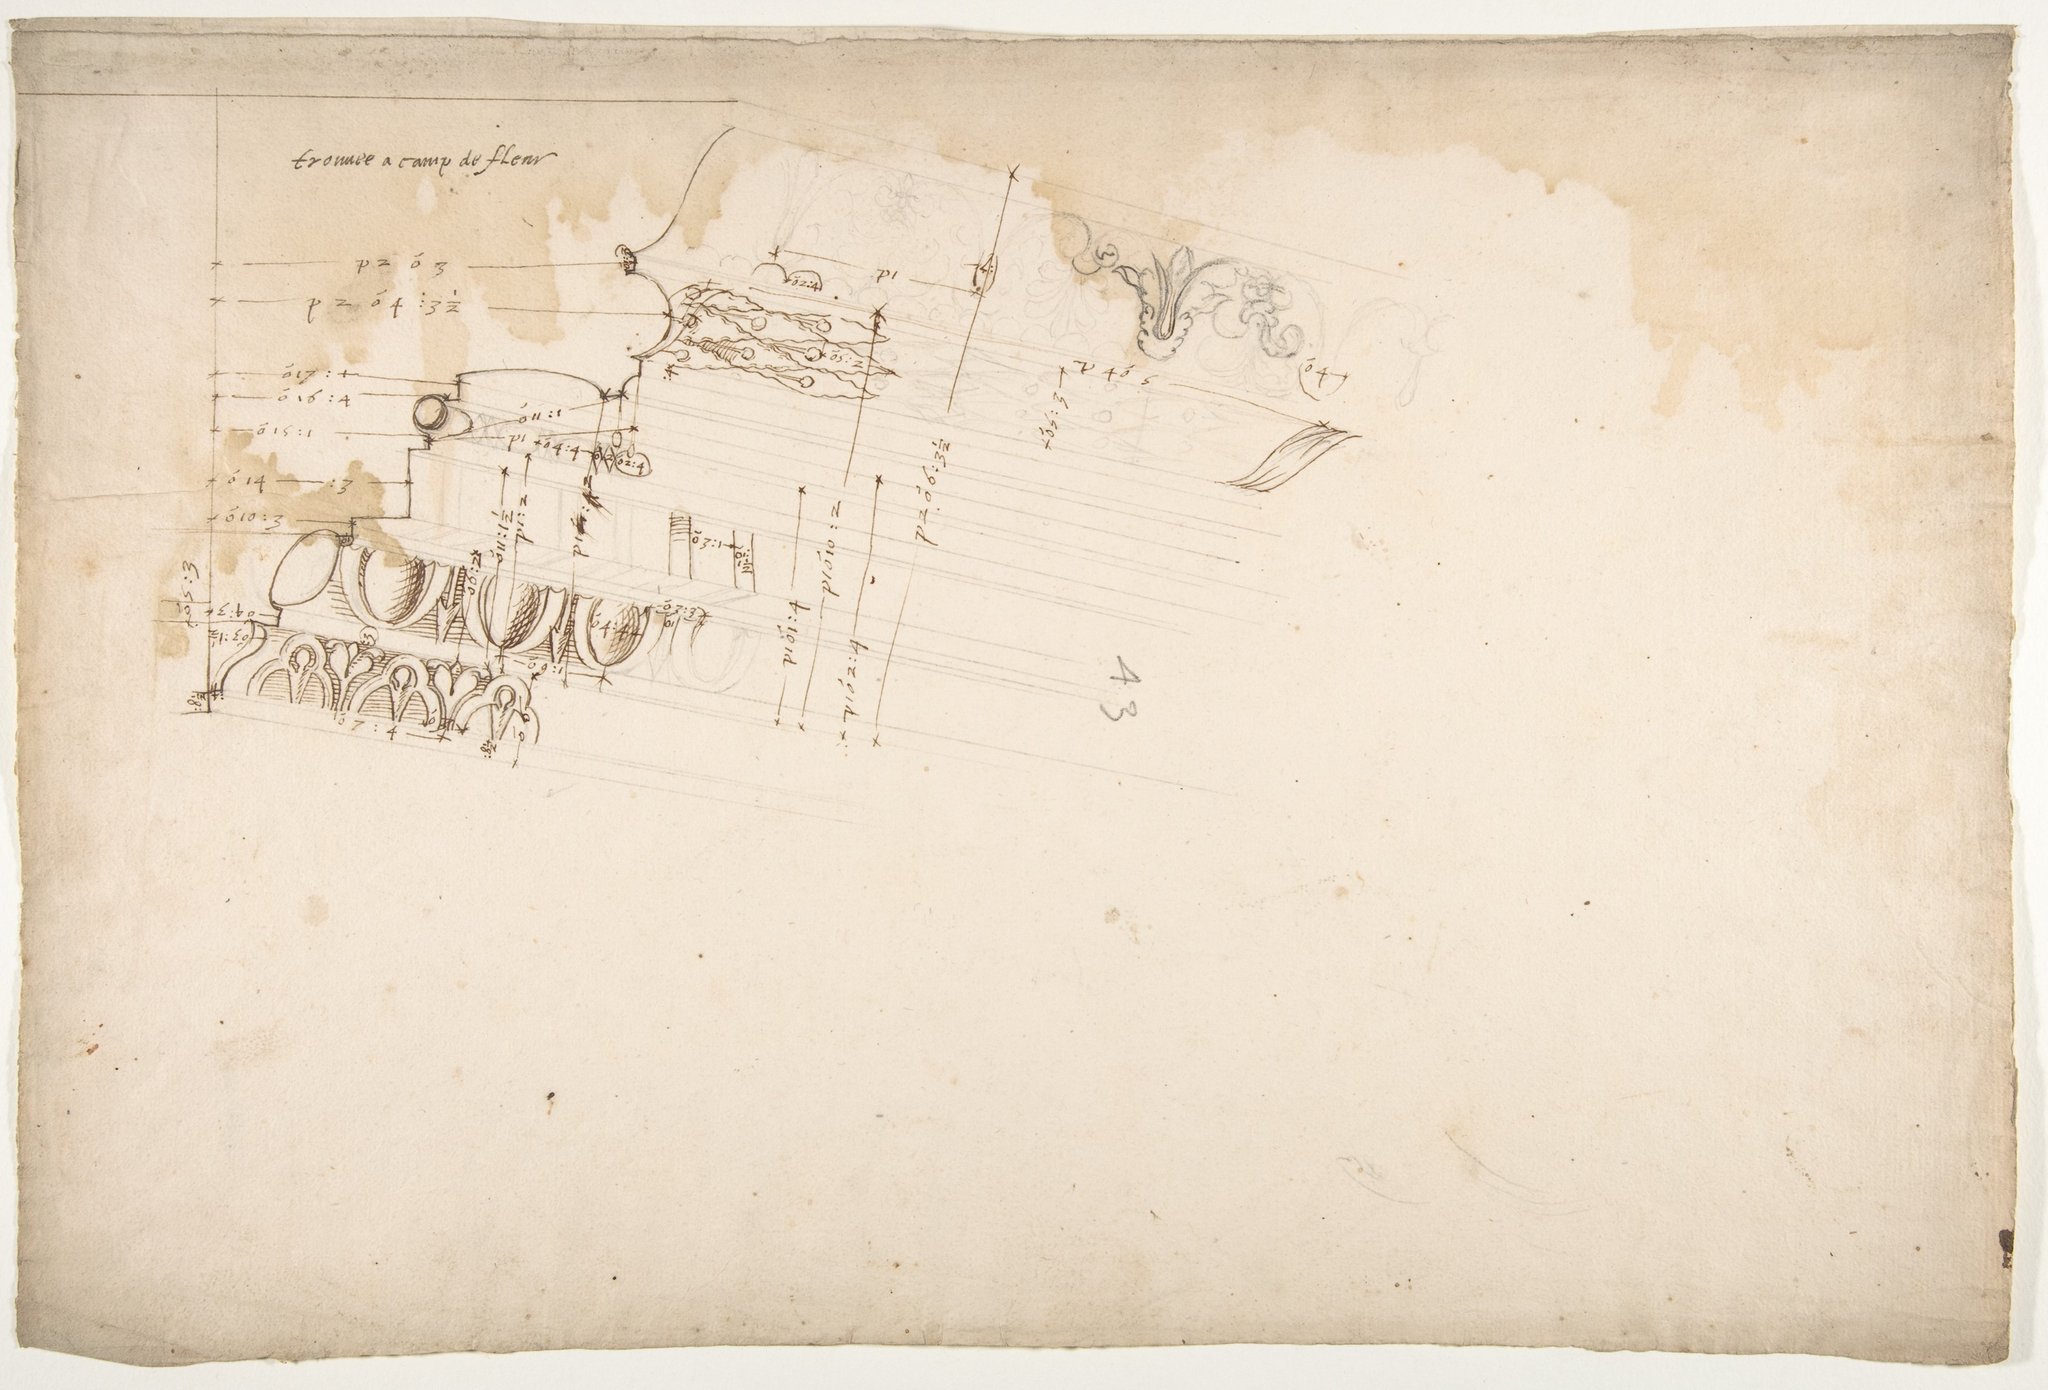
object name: collection ornament architecture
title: Unidentified, cornice, projection (recto) blank (verso)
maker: anonymous, french, 16th century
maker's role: draftsman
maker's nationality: french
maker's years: 1500-1600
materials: chalk, ink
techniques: incising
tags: architecture